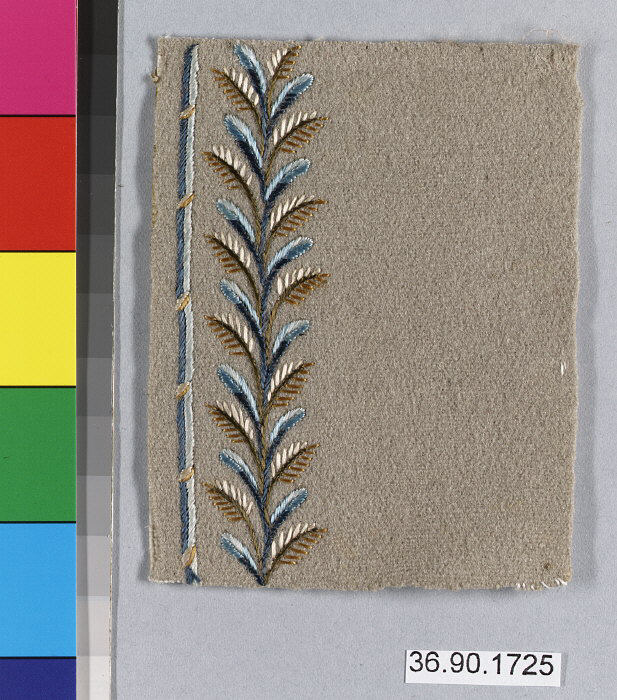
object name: sample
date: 1801-1833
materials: felt, silk